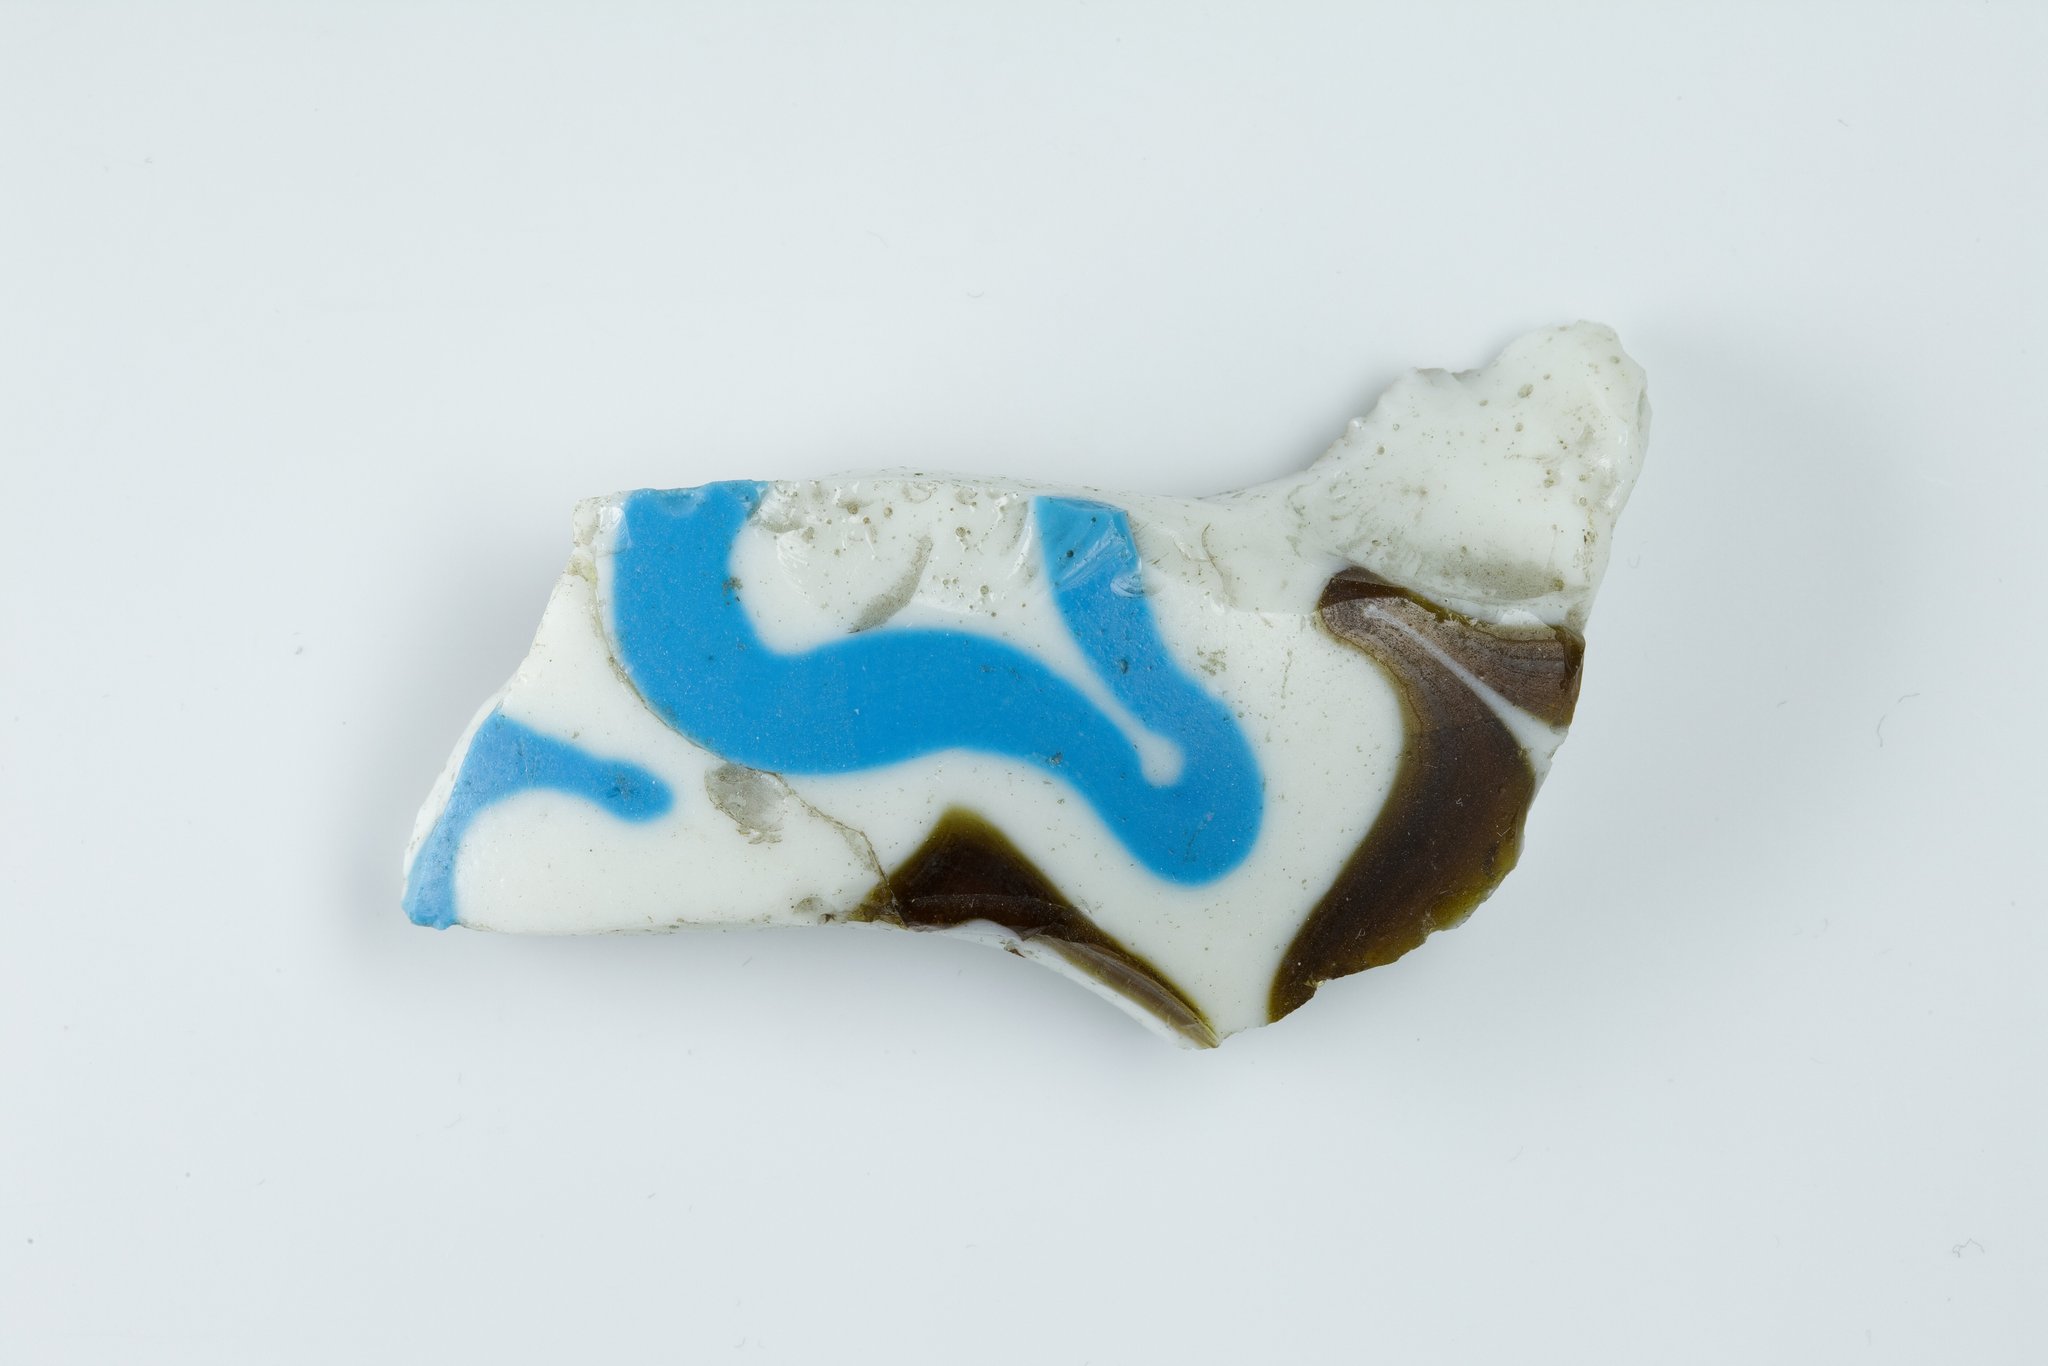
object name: vessel fragment, patterned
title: Fragments from Patterned Vessels with Thick Walls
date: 1427-1400 BCE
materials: glass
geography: egypt